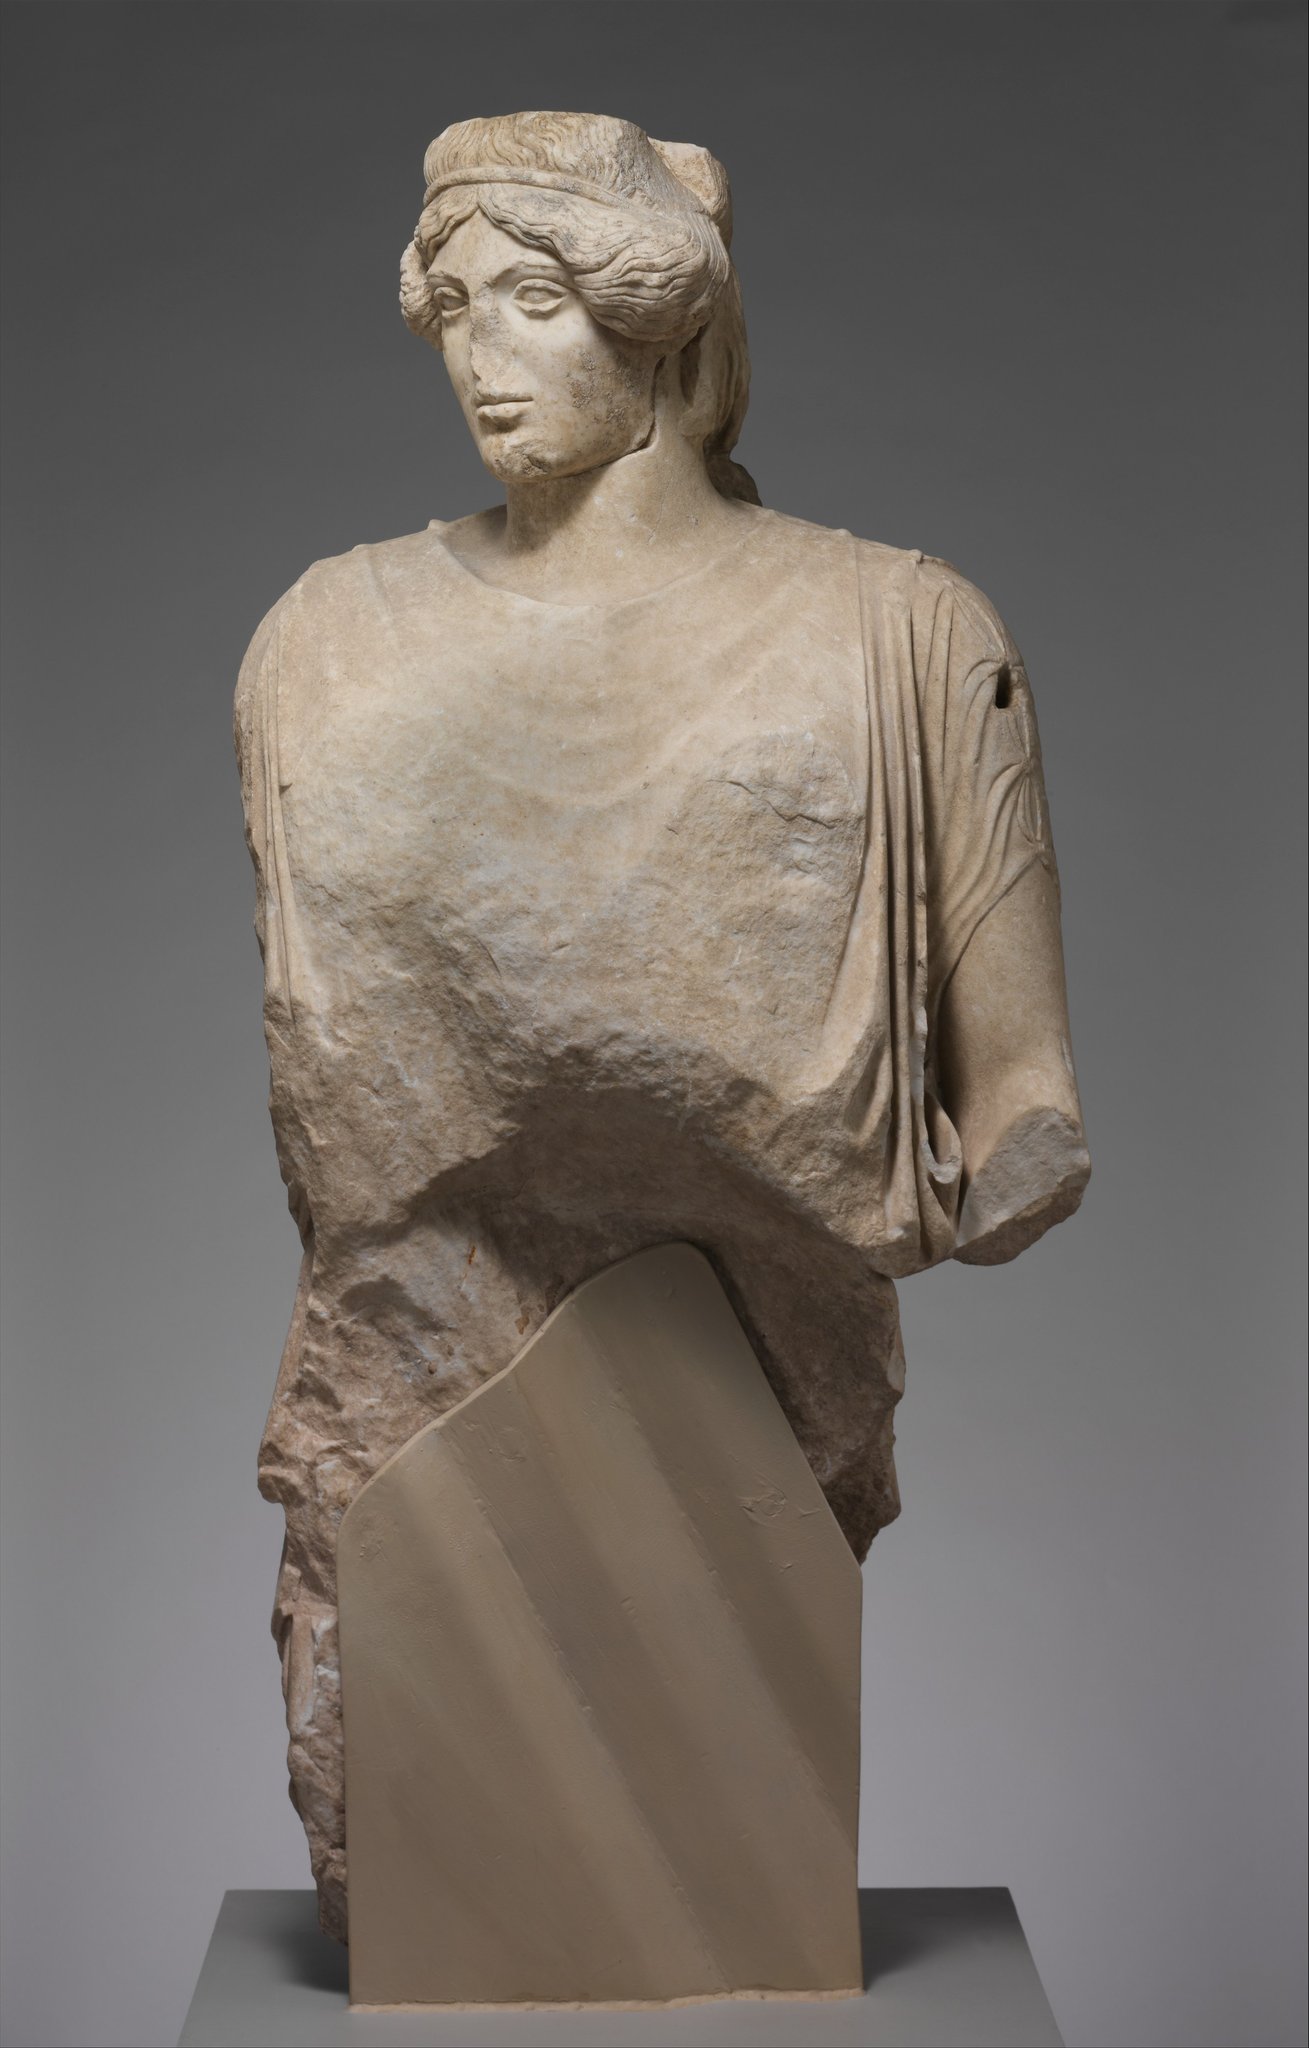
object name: statue of athena, fragmentary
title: Upper part of a marble statue of a woman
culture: roman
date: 1-200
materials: marble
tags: helmets,women